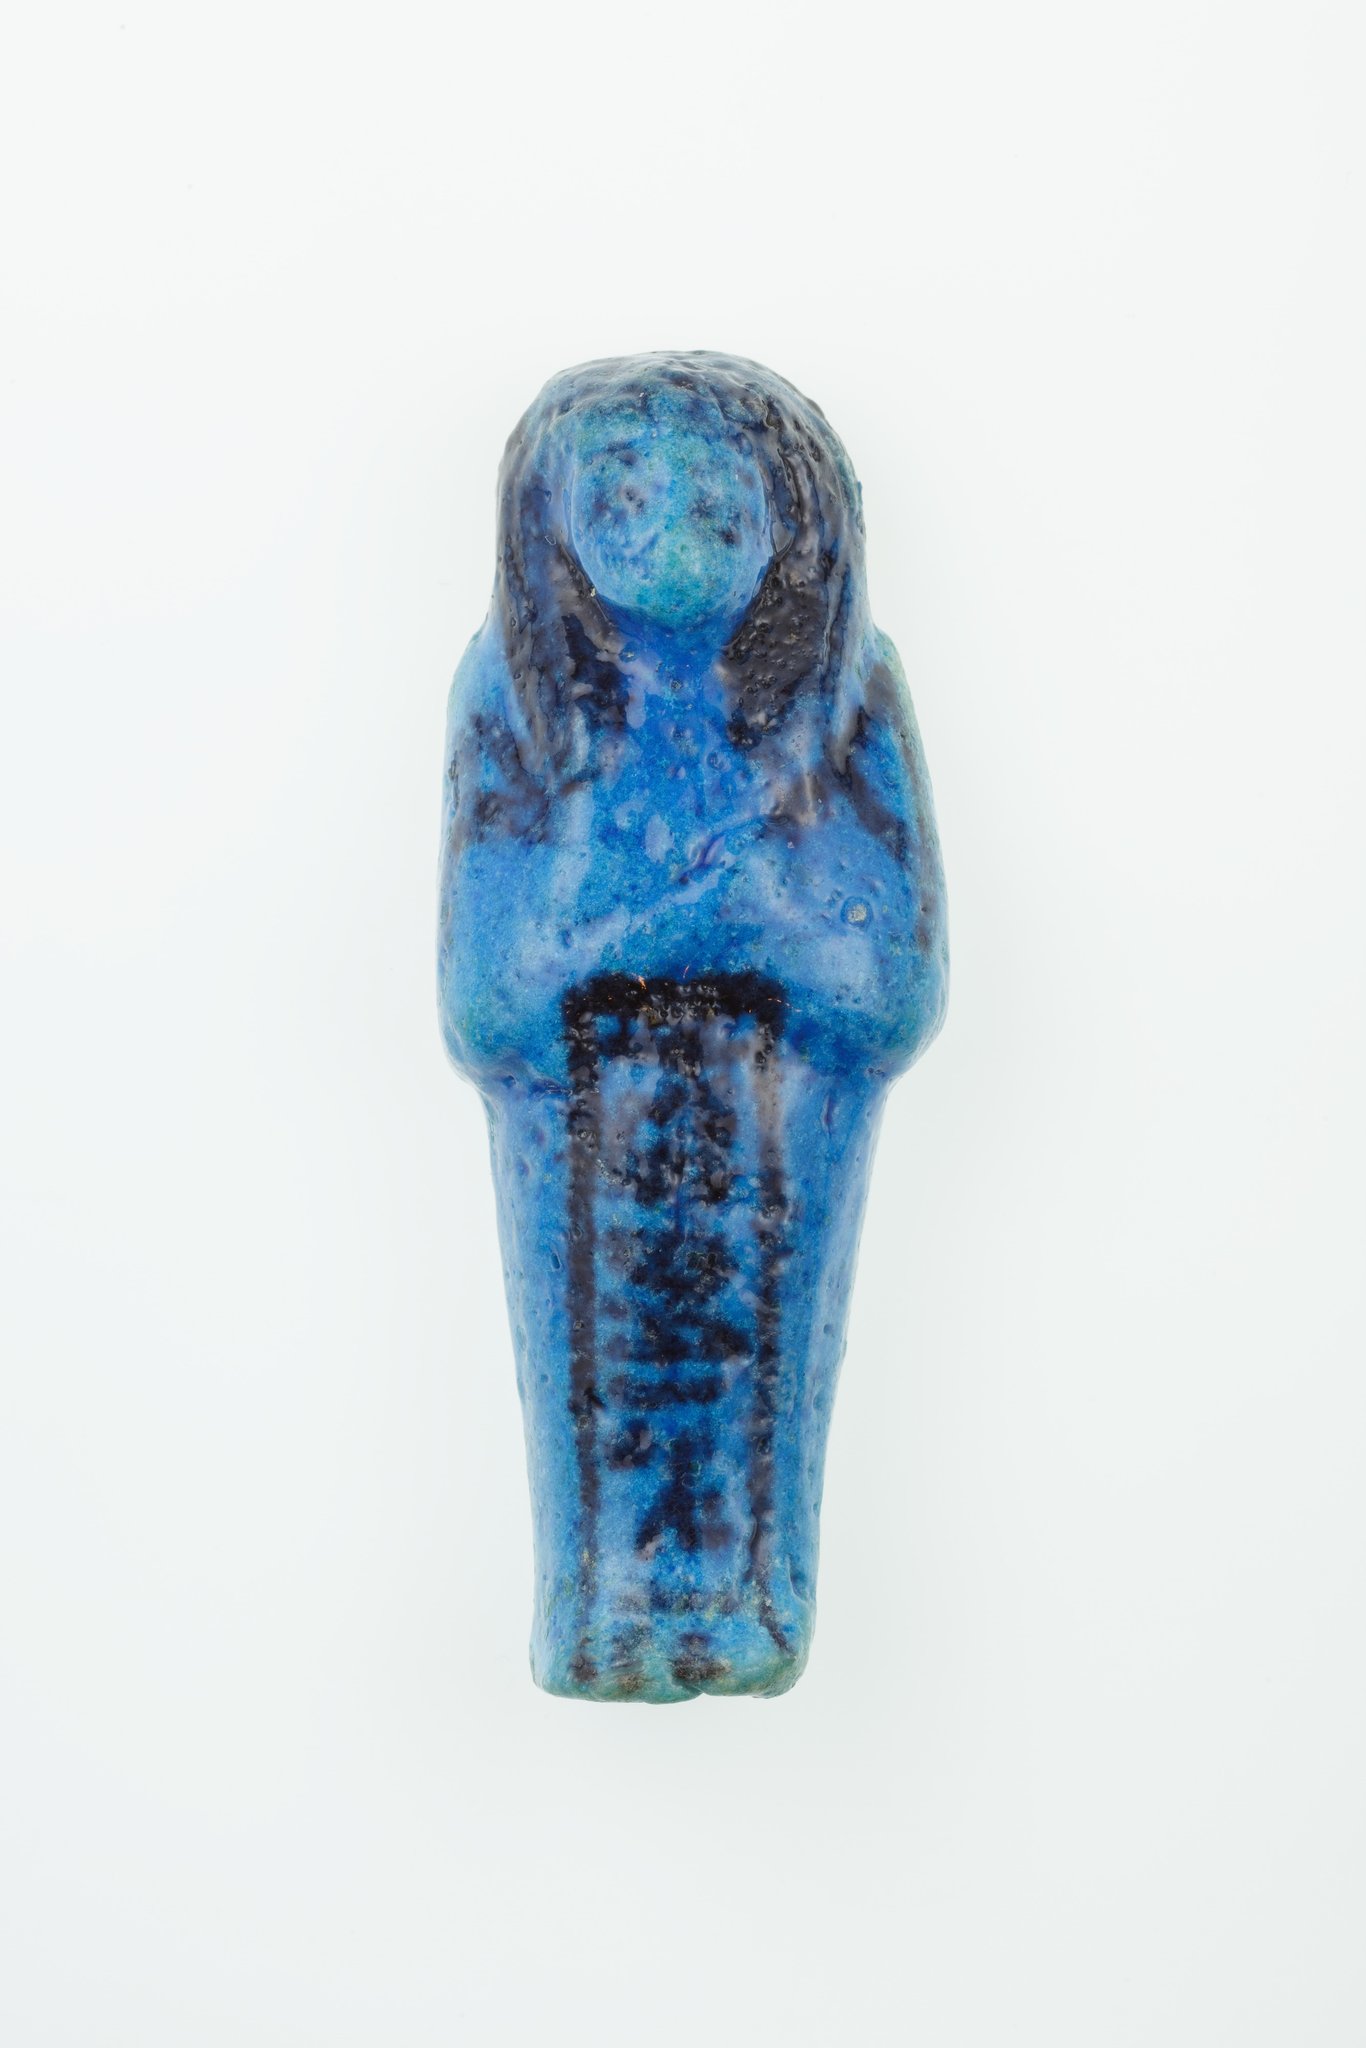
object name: shabti, worker, nauny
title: Worker Shabti of Nauny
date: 1050 BCE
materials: faience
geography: egypt